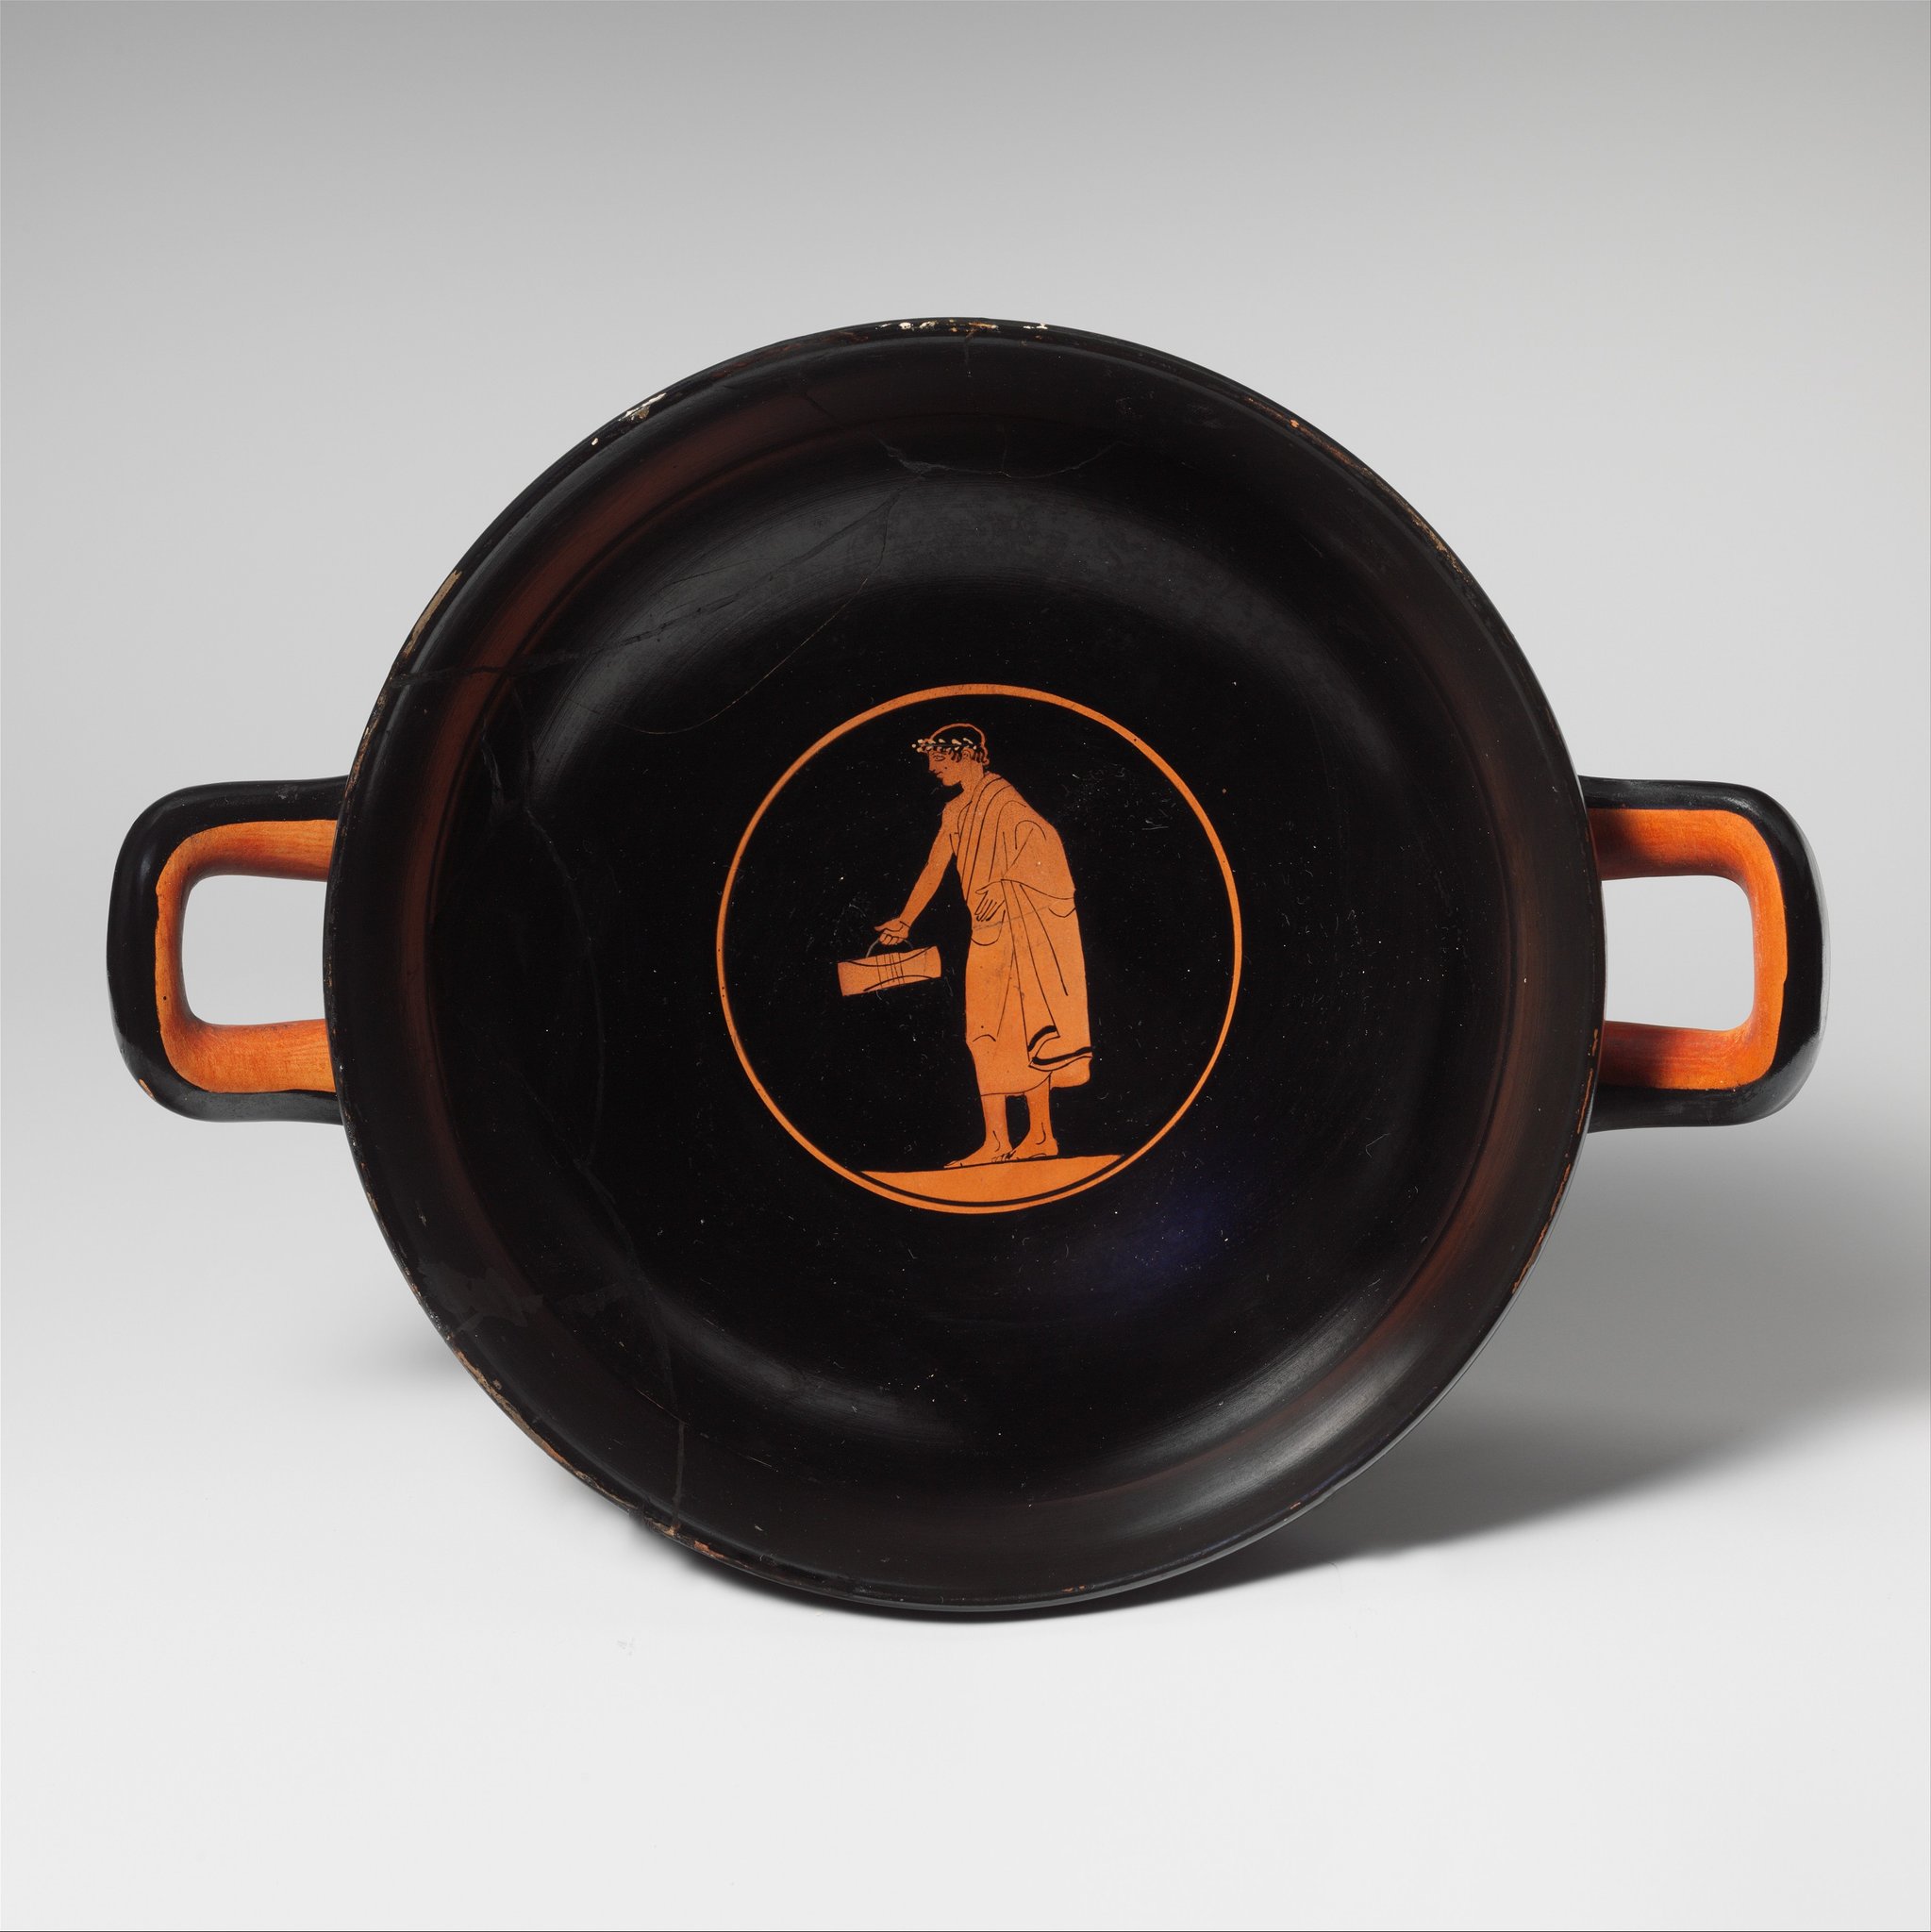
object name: kylix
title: Terracotta kylix (drinking cup)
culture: greek, attic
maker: painter of munich 2660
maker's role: artist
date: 460 BCE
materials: terracotta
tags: boys